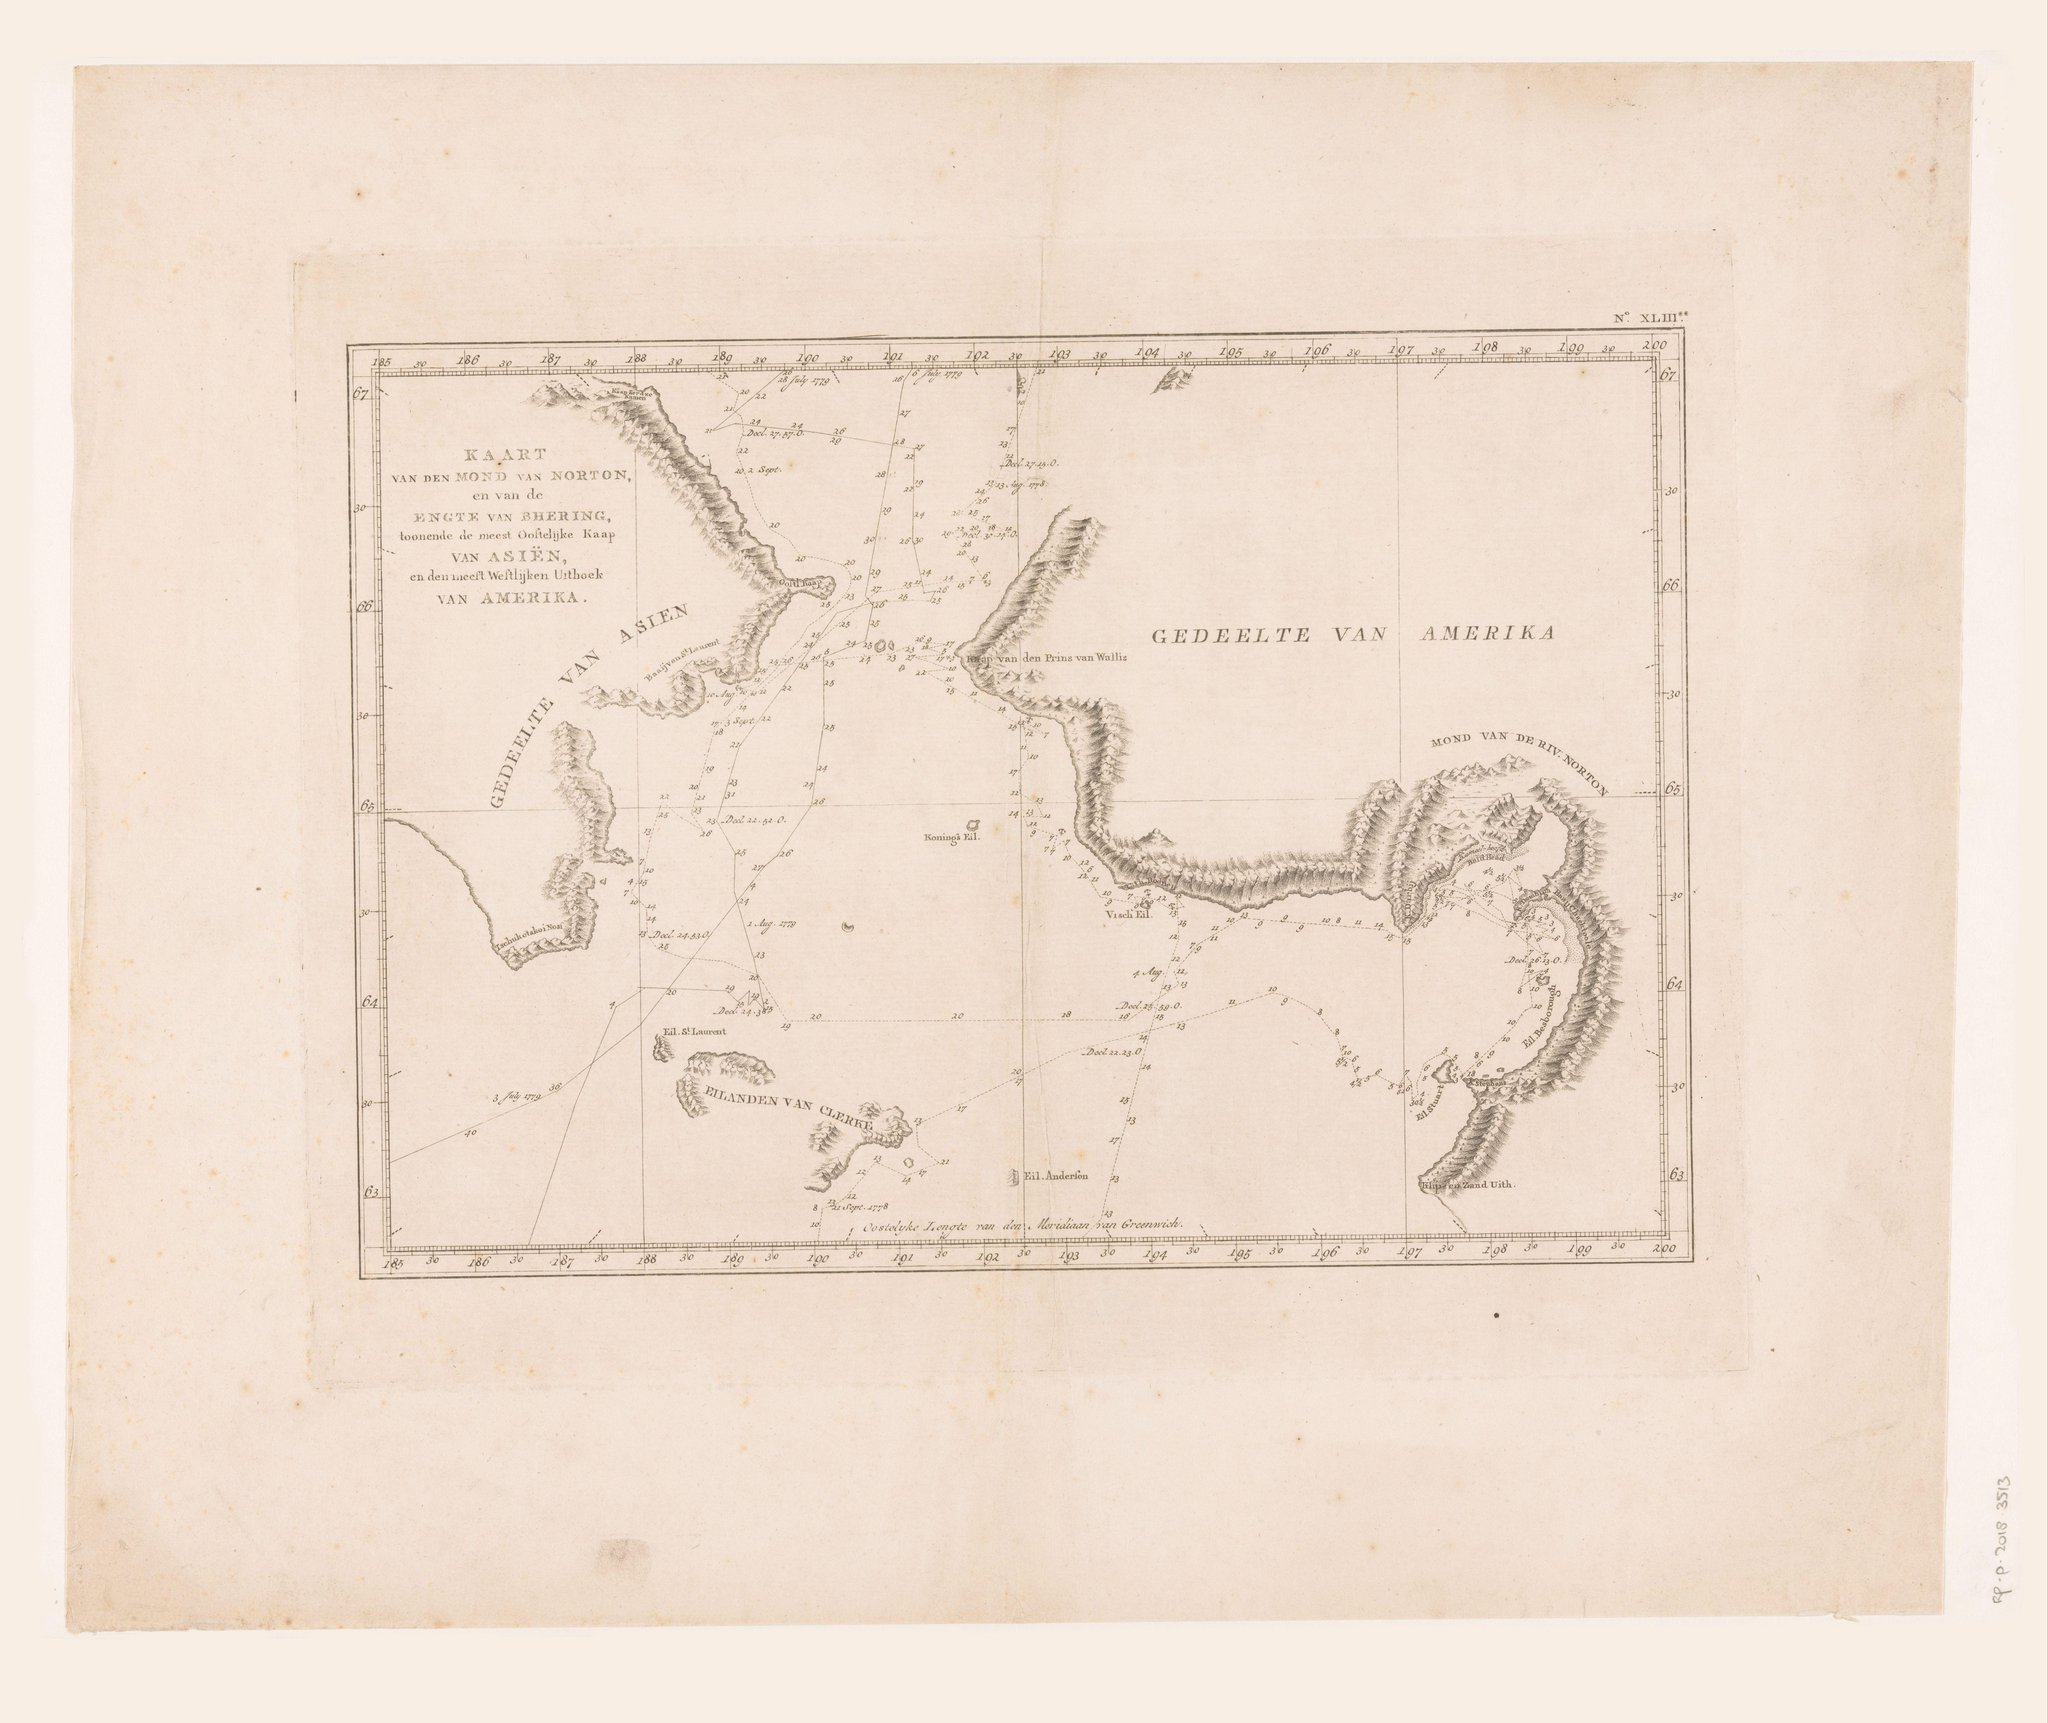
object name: print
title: Kaart van den mond van Norton en van de engte van Bhering, toonende de meest oostelijke Kaap van Asiën, en den meest westelijken uithoek van Amerika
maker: Anonymous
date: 1795-1803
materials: paper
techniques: engraving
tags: maps of separate countries or regions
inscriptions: collector's mark: Lugt 2228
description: Prent uit: Cook, James. Reizen rondom de waereld, 13 dln. Leiden, Amsterdam en Den Haag: Honkoop, Allart en Van Cleef, 1795-1803.